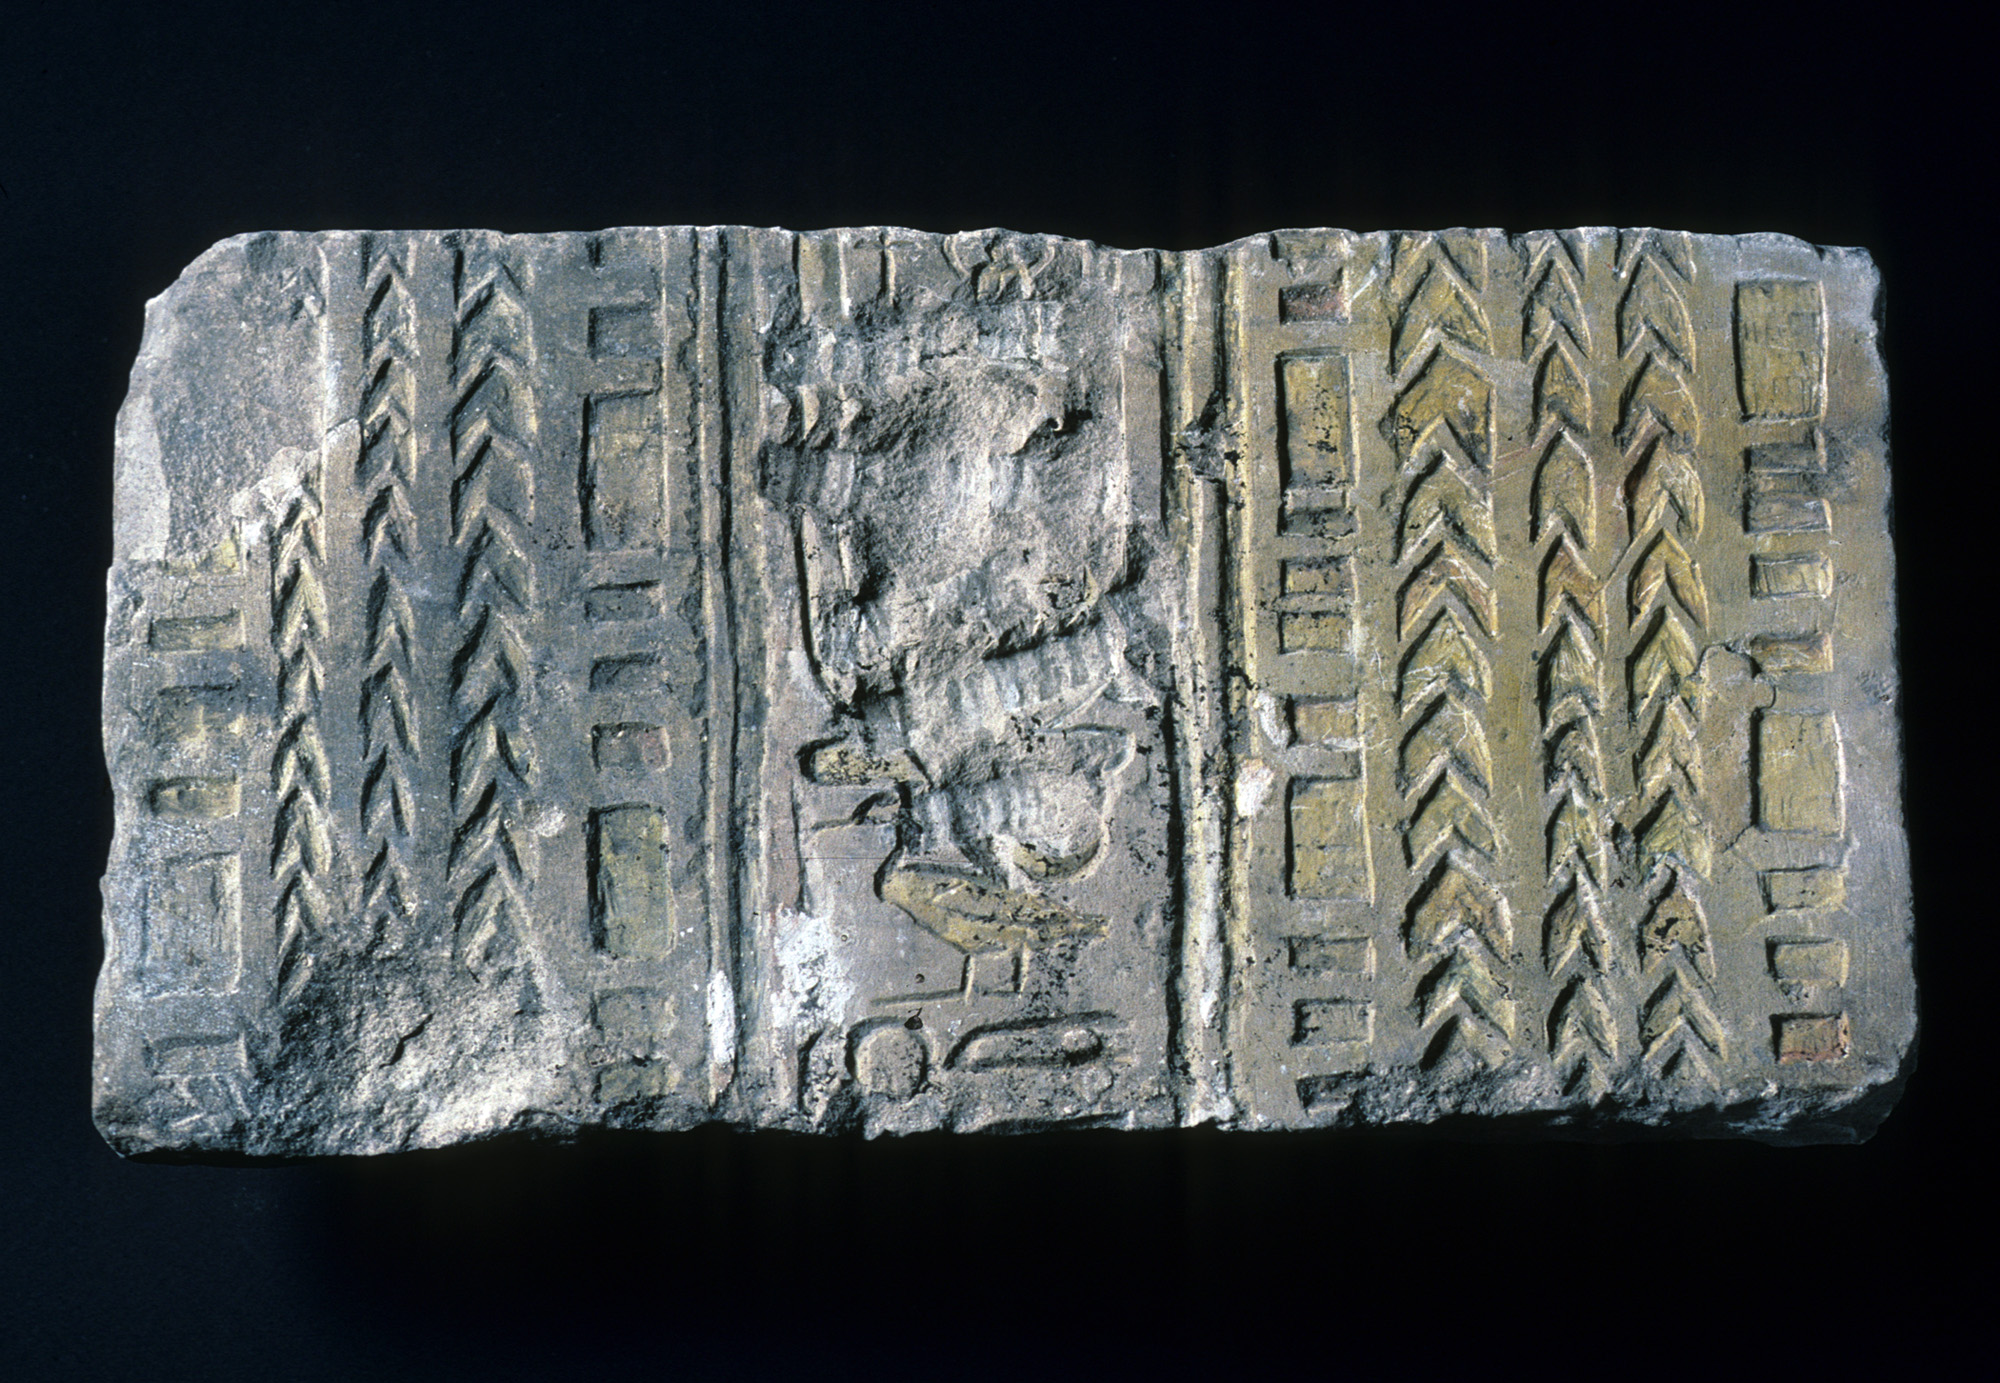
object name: talatat, akhenaten's cartouche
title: Relief with Akhenaten's cartouche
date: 1353-1336 BCE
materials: limestone, paint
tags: cartouches